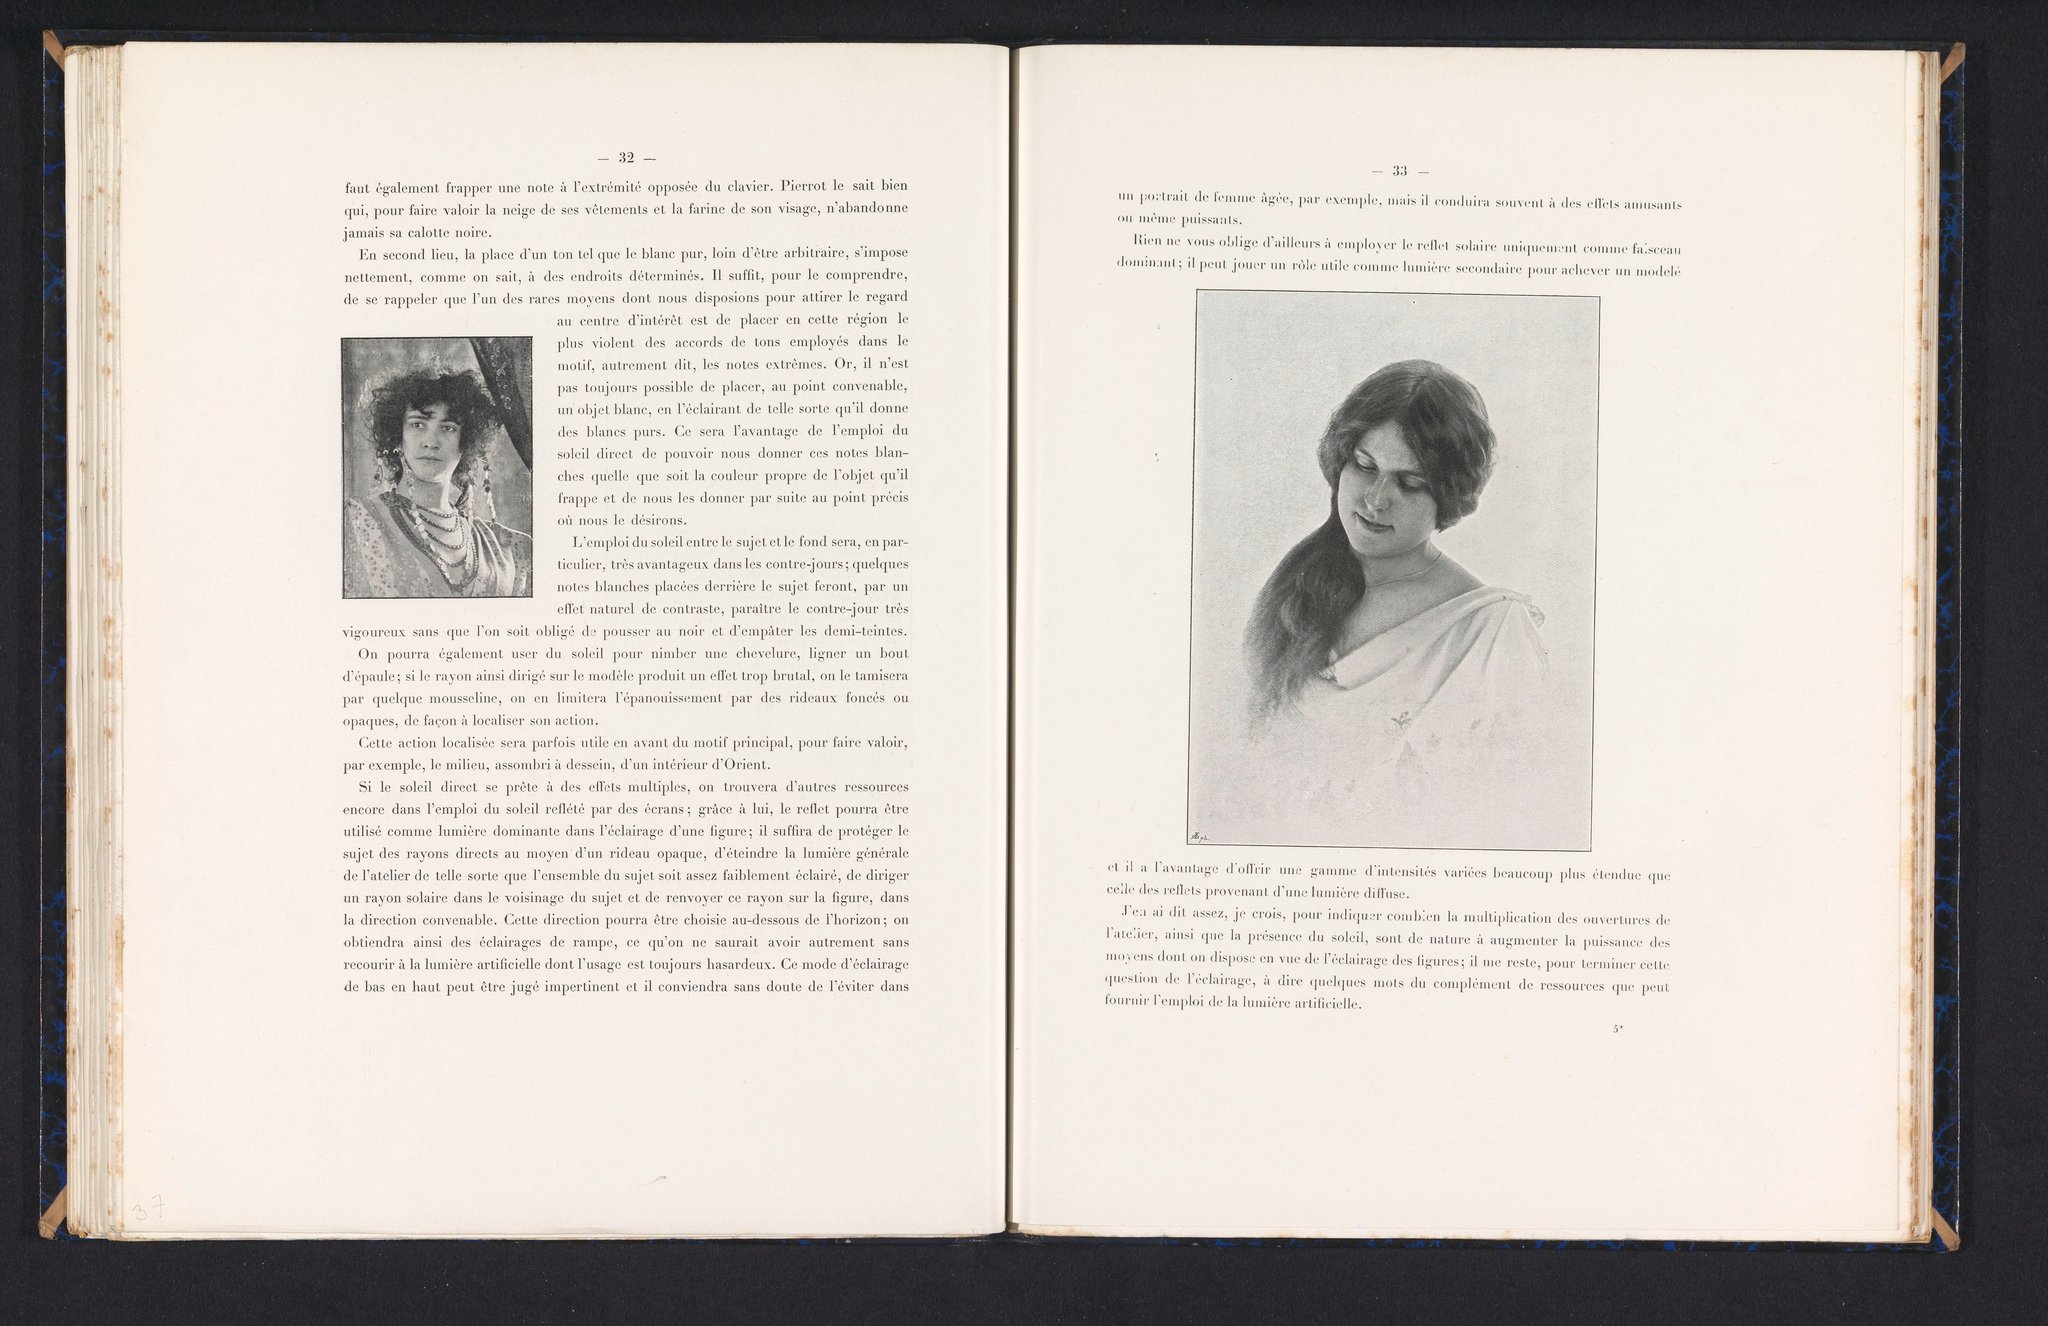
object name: page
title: Portret van een onbekende vrouw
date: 1886-1896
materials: paper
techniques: autotype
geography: france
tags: anonymous historical person portrayed - bb - woman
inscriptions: inscription: ‘BC ph.’